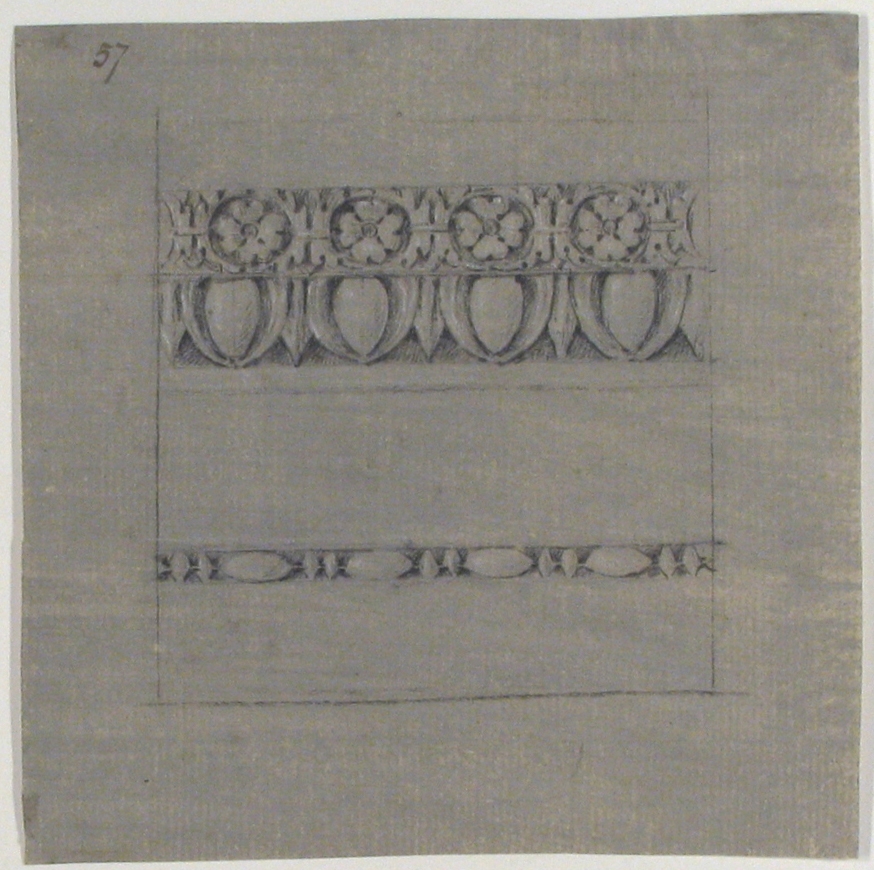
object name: drawing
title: Design for Molding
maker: anonymous, french, 19th century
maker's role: artist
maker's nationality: french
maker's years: 1800-1900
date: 1825-1850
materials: chalk, graphite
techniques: heightening